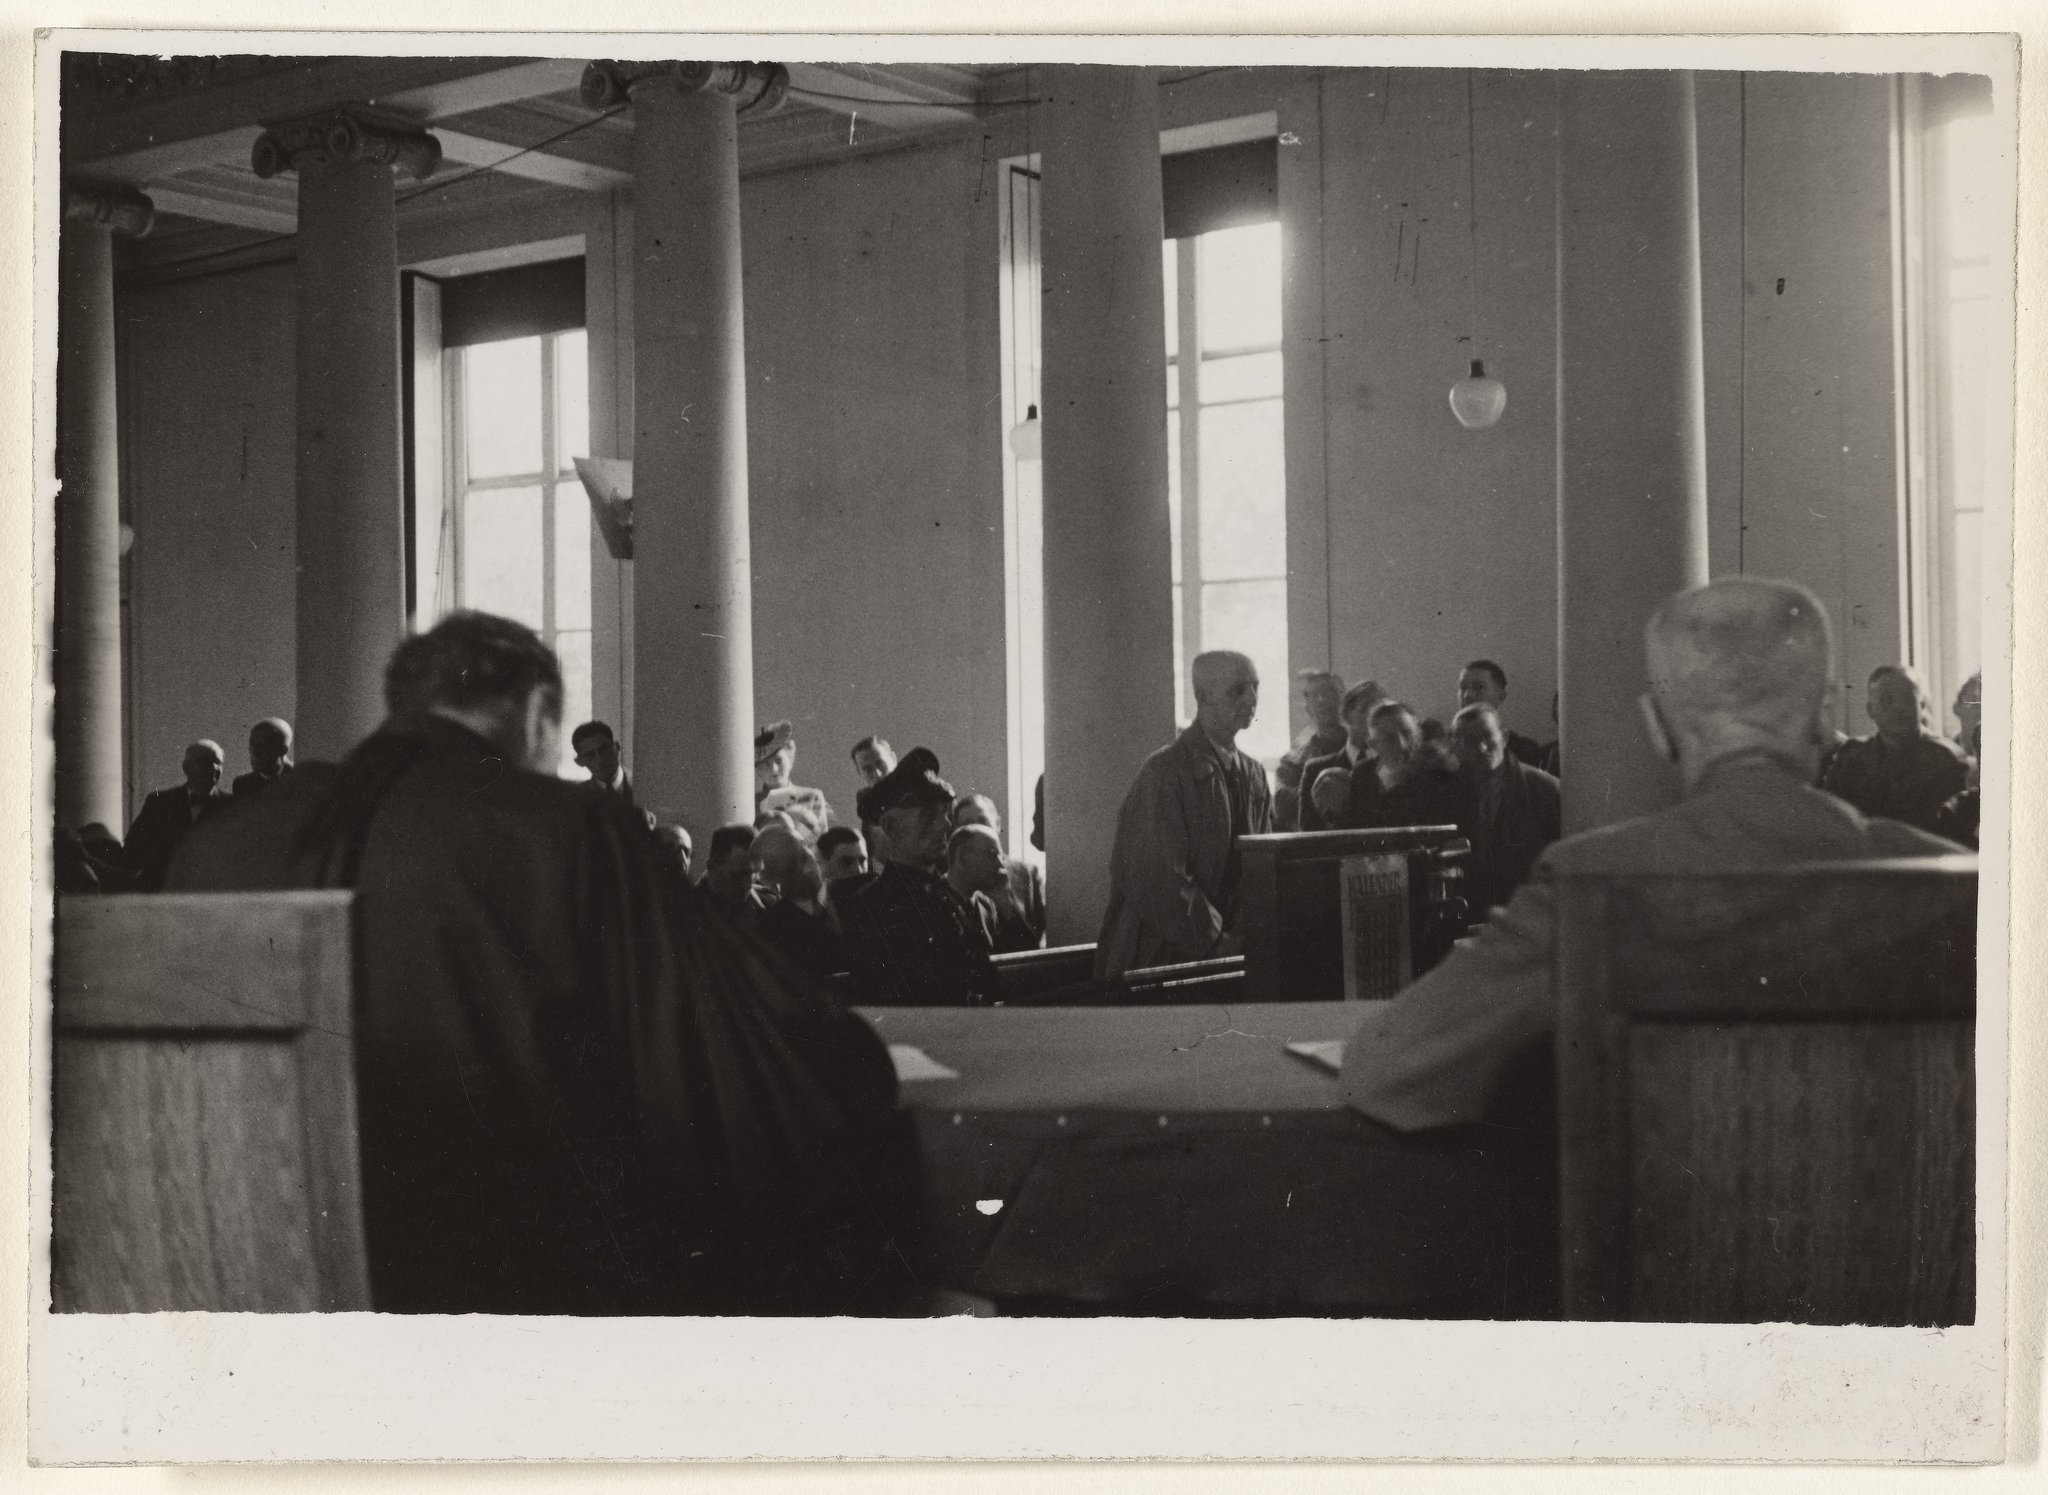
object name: photograph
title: Proces Max Blokzijl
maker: Anonymous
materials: photographic support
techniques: photography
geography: the hague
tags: max blokzijl, the hague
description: Het proces vond plaats in het paleis aan de Kneuterdijk. Blokzijl werd, als eerste collaborateur, ter dood veroordeeld en op 16 maart 1946 gefusilleerd. [Baruch, Jet, 2006].